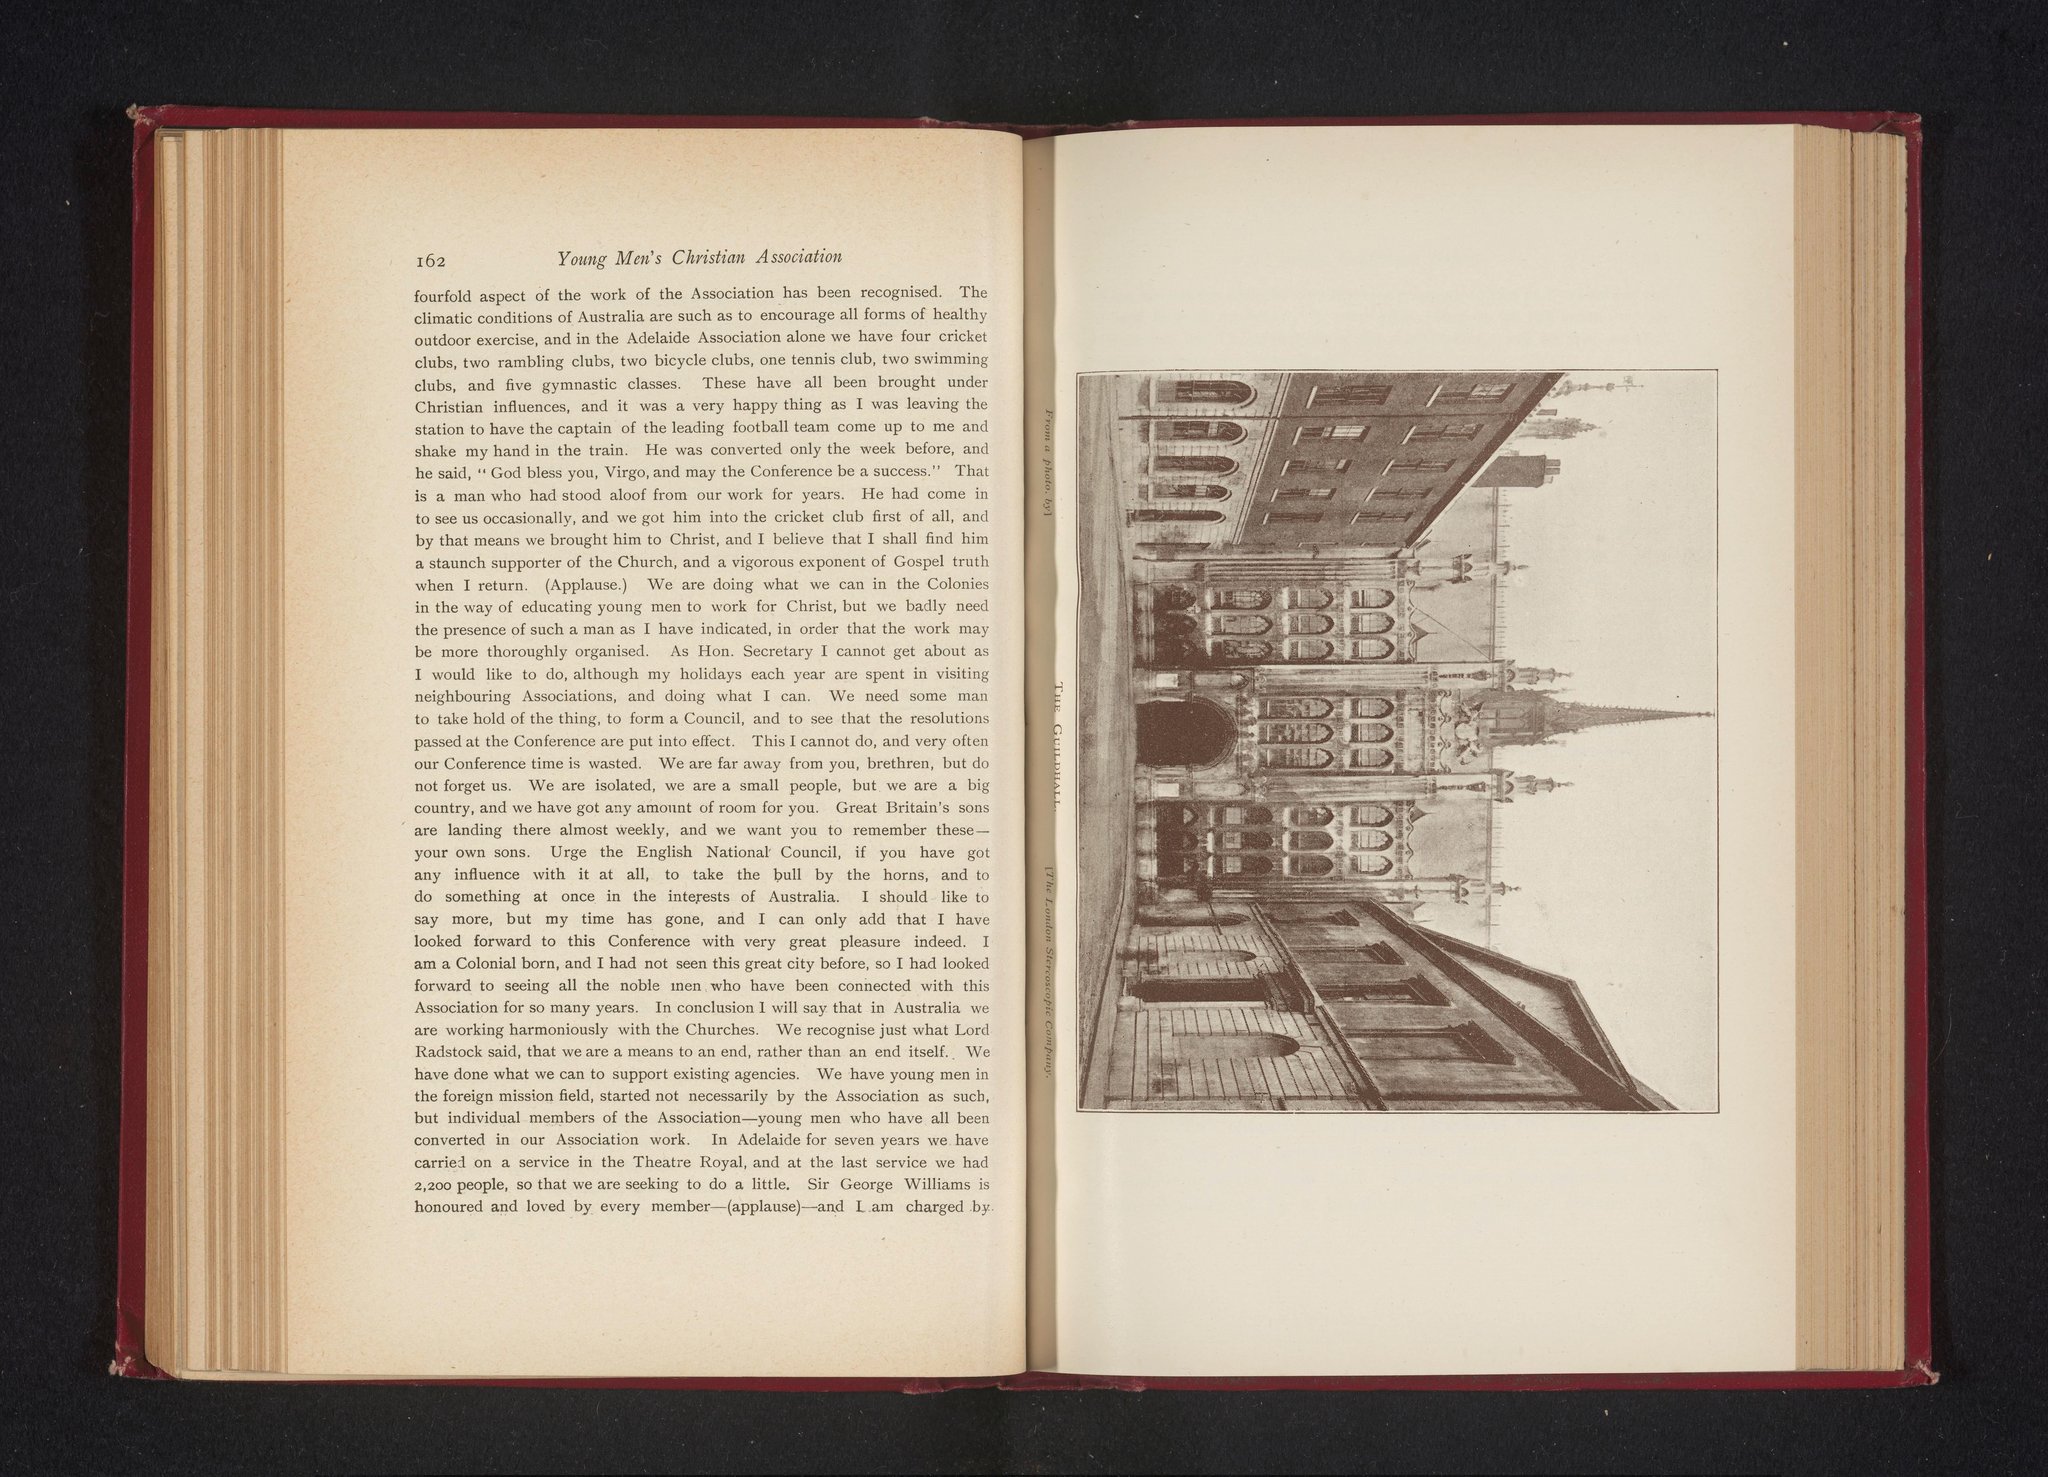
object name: page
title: The Guildhall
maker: Anonymous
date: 1890-1895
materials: paper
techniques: autotype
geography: london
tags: townhall